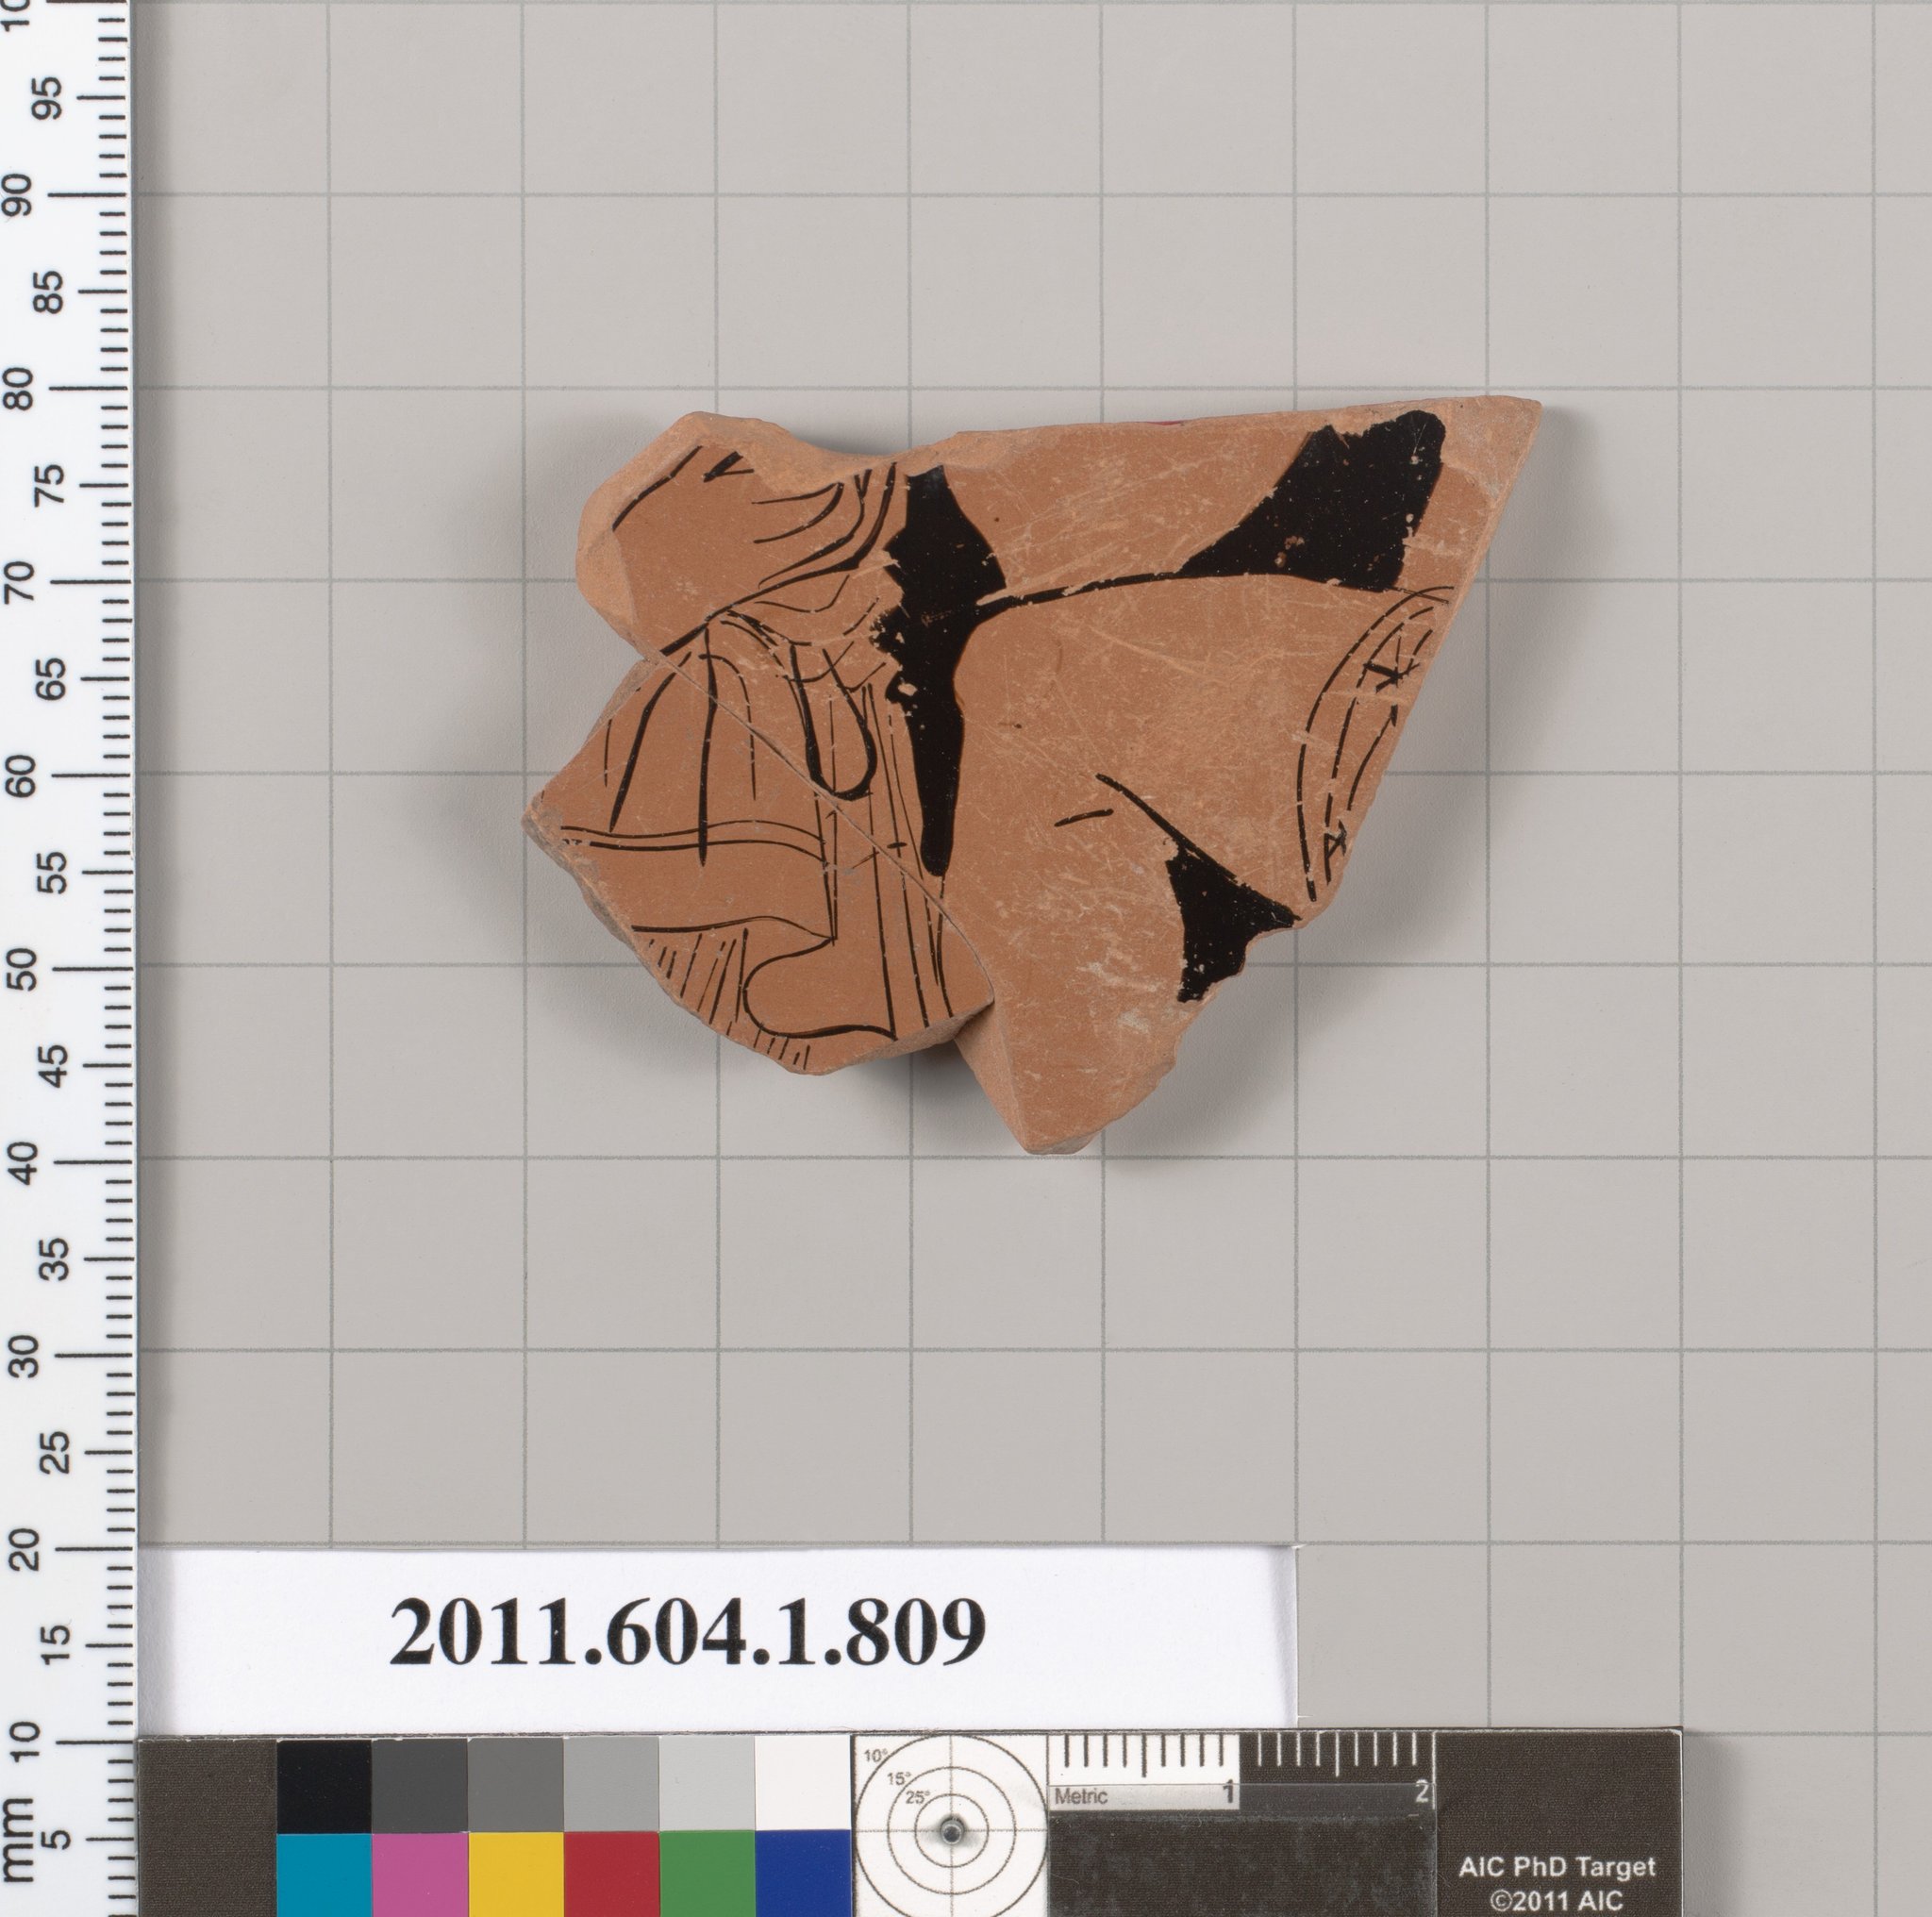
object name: kylix fragment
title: Terracotta fragment of a kylix (drinking cup)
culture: greek, attic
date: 451-500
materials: terracotta